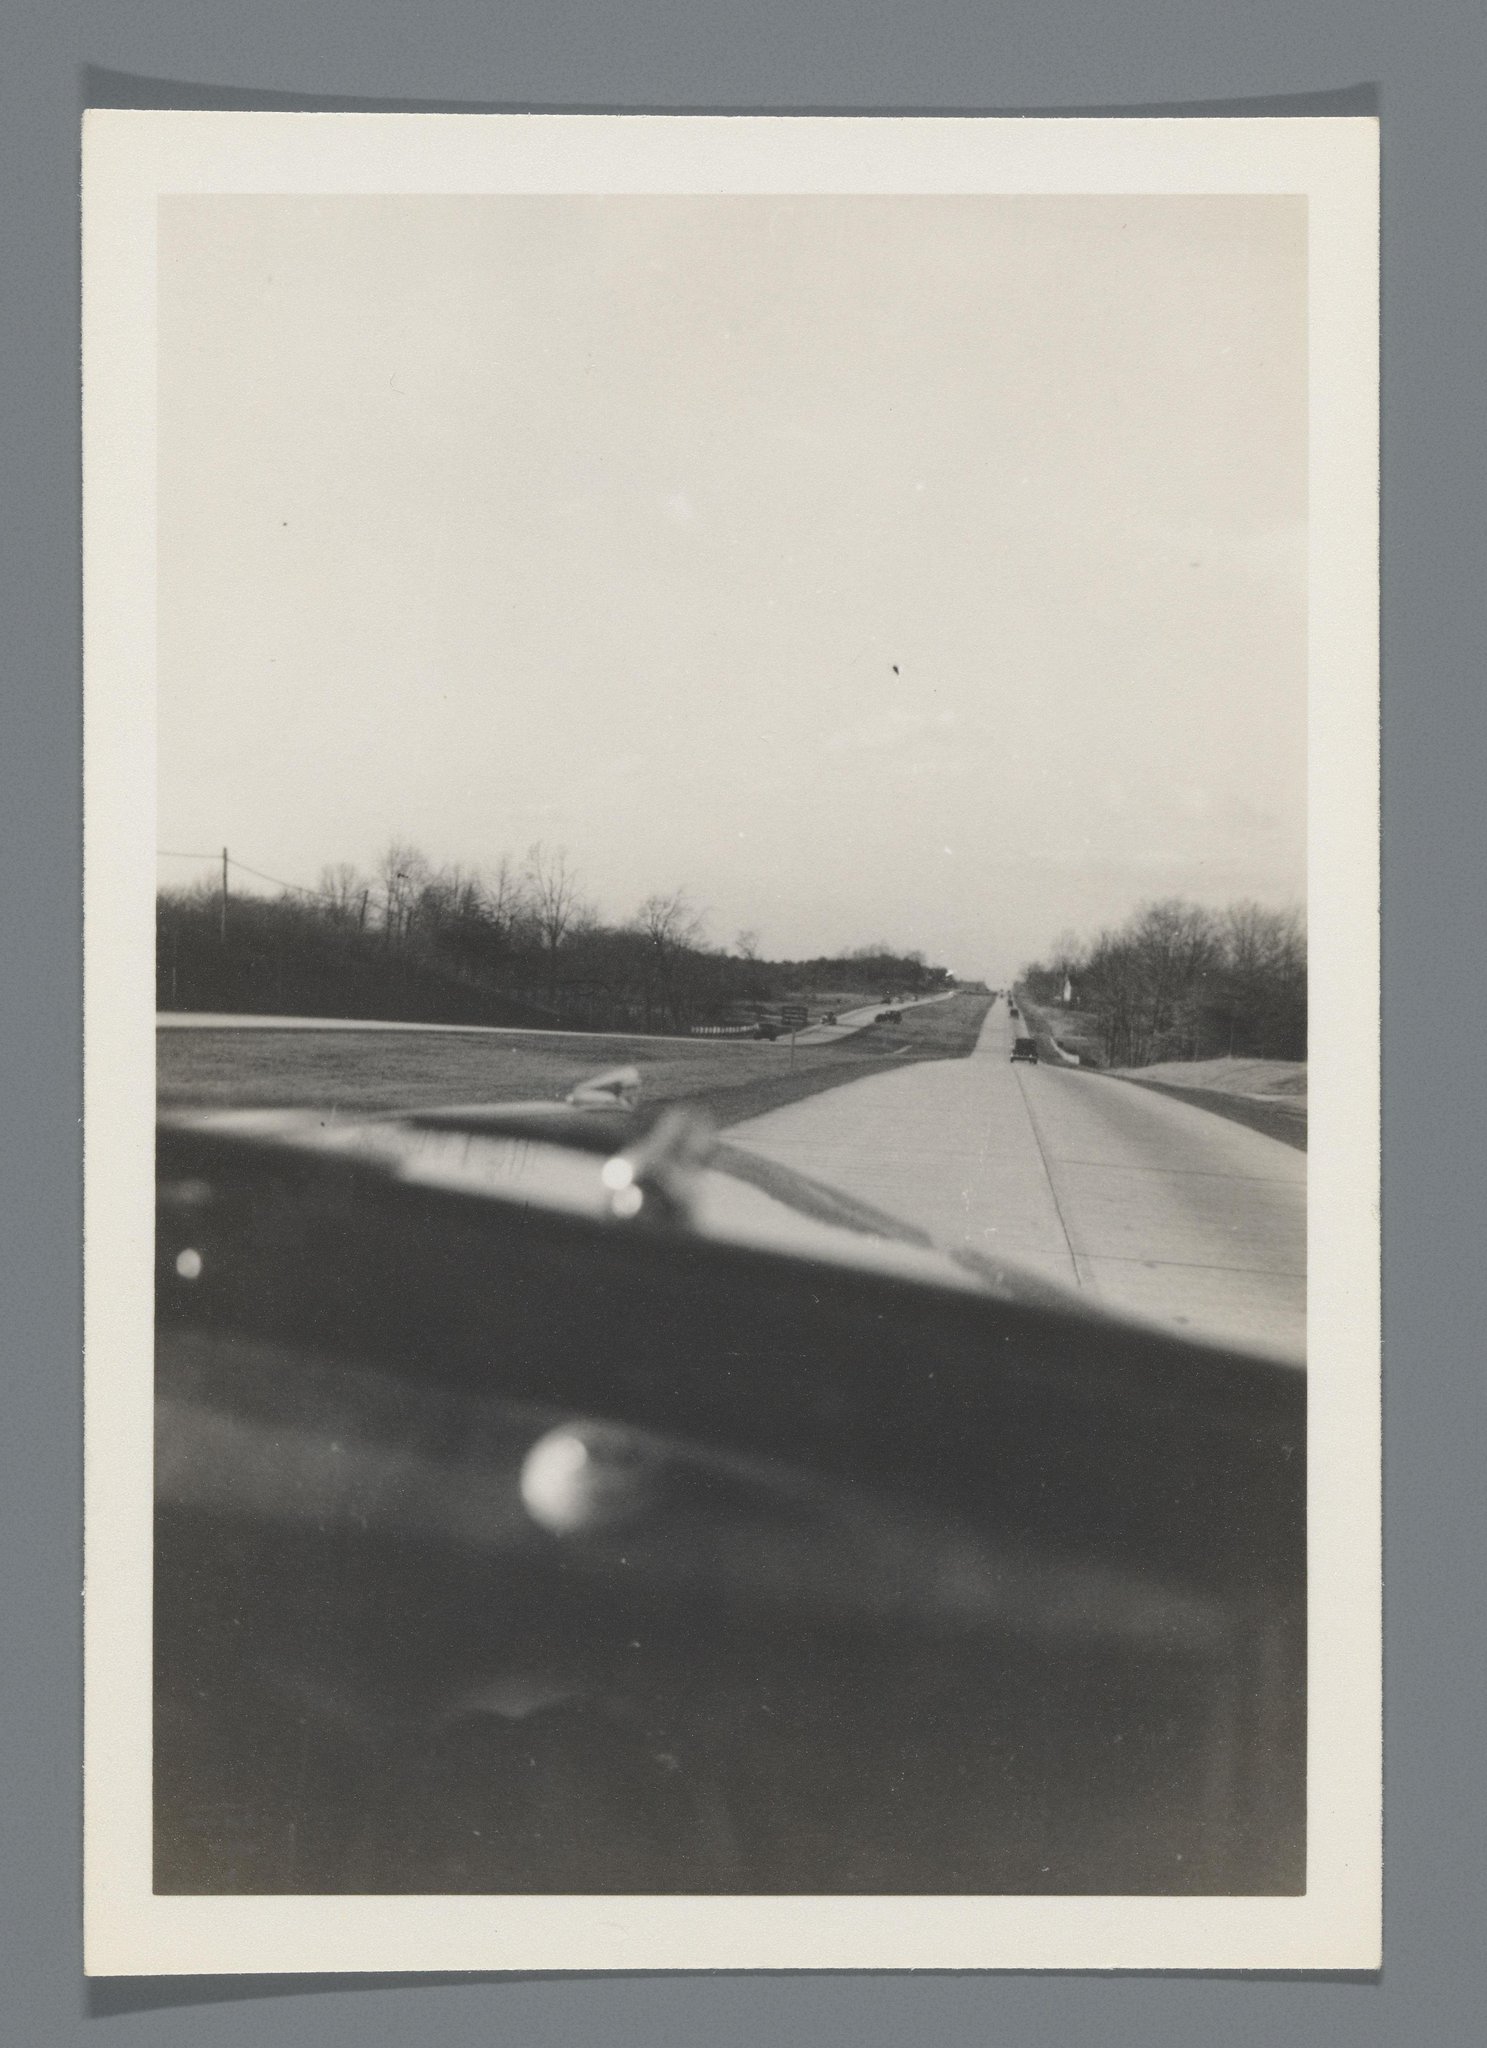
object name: photograph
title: Gezicht vanuit een rijdende auto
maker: Anonymous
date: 1940-1950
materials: paper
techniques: gelatin silver print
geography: united states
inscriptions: inscription: ‘38 BUICK?’, inscription: ‘…. GE EKS 459’